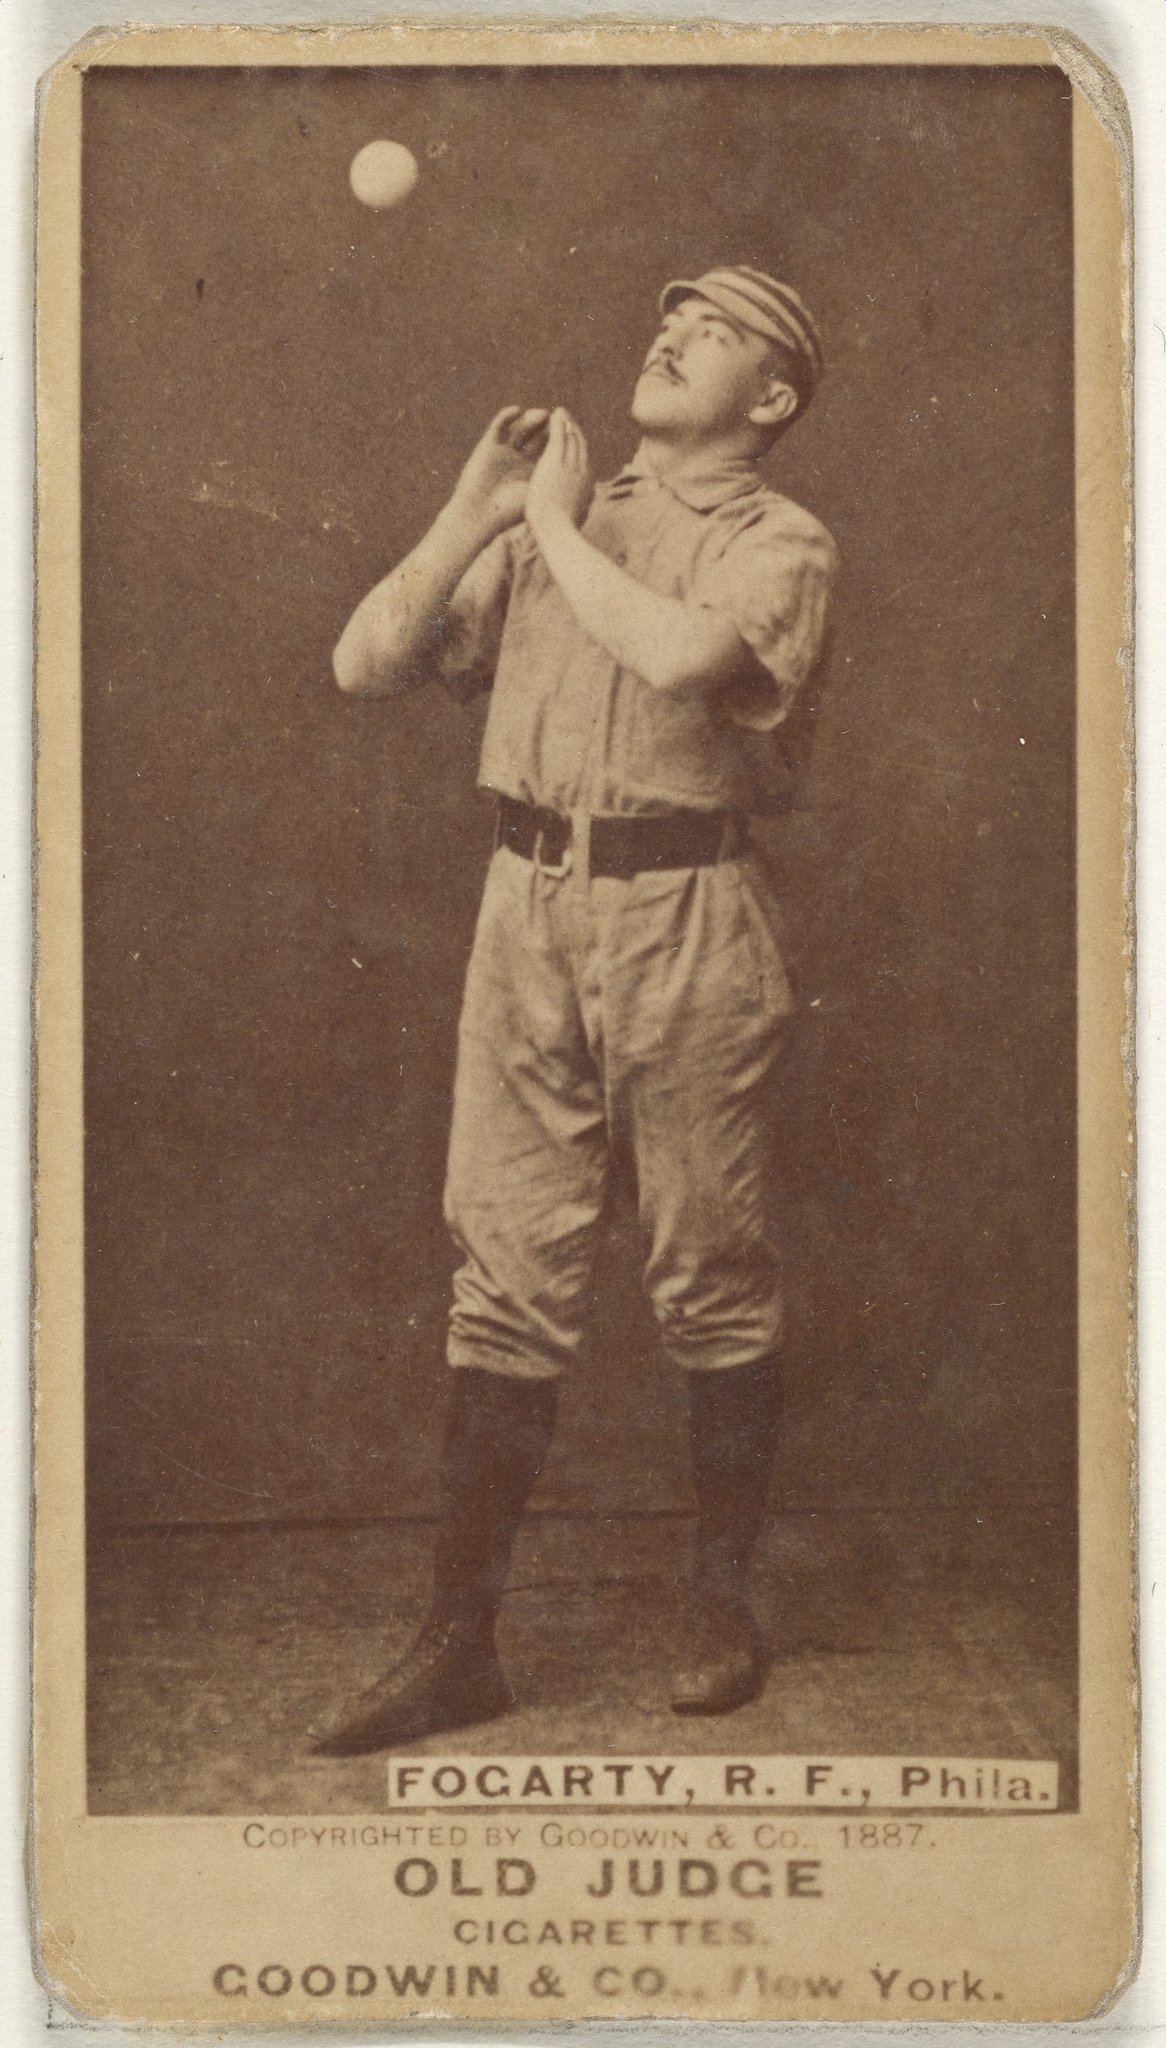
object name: baseball card, photograph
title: James G. Fogarty, Right Field, Philadelphia, from the Old Judge series (N172) for Old Judge Cigarettes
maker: goodwin & company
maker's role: publisher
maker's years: 1850-1950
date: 1887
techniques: albumen silver print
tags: men,portraits,baseball,athletes